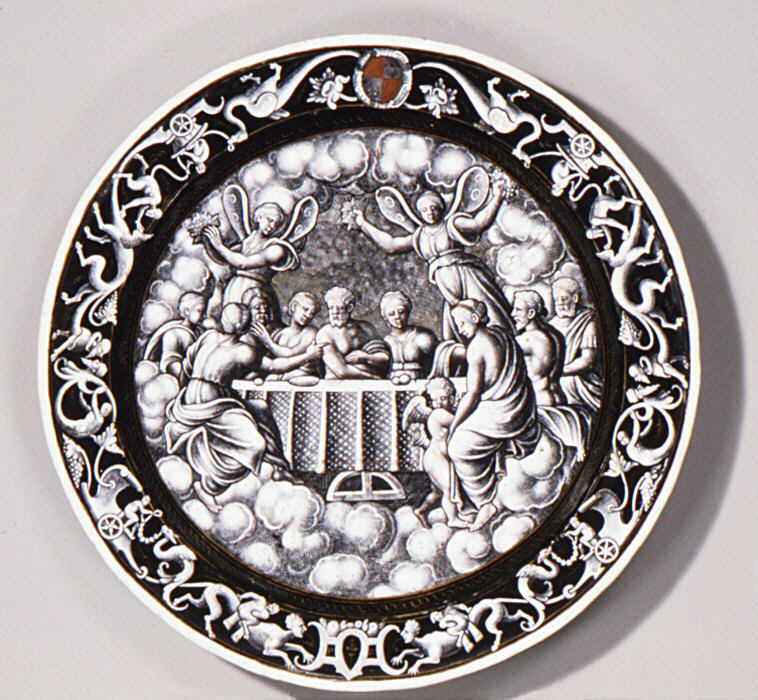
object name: plate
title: The Wedding Feast of Cupid and Psyche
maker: pierre reymond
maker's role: enameler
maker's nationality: french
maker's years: 1513-1590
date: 1570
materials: copper, enamel, gilt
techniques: painting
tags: men,women,cupid,psyche